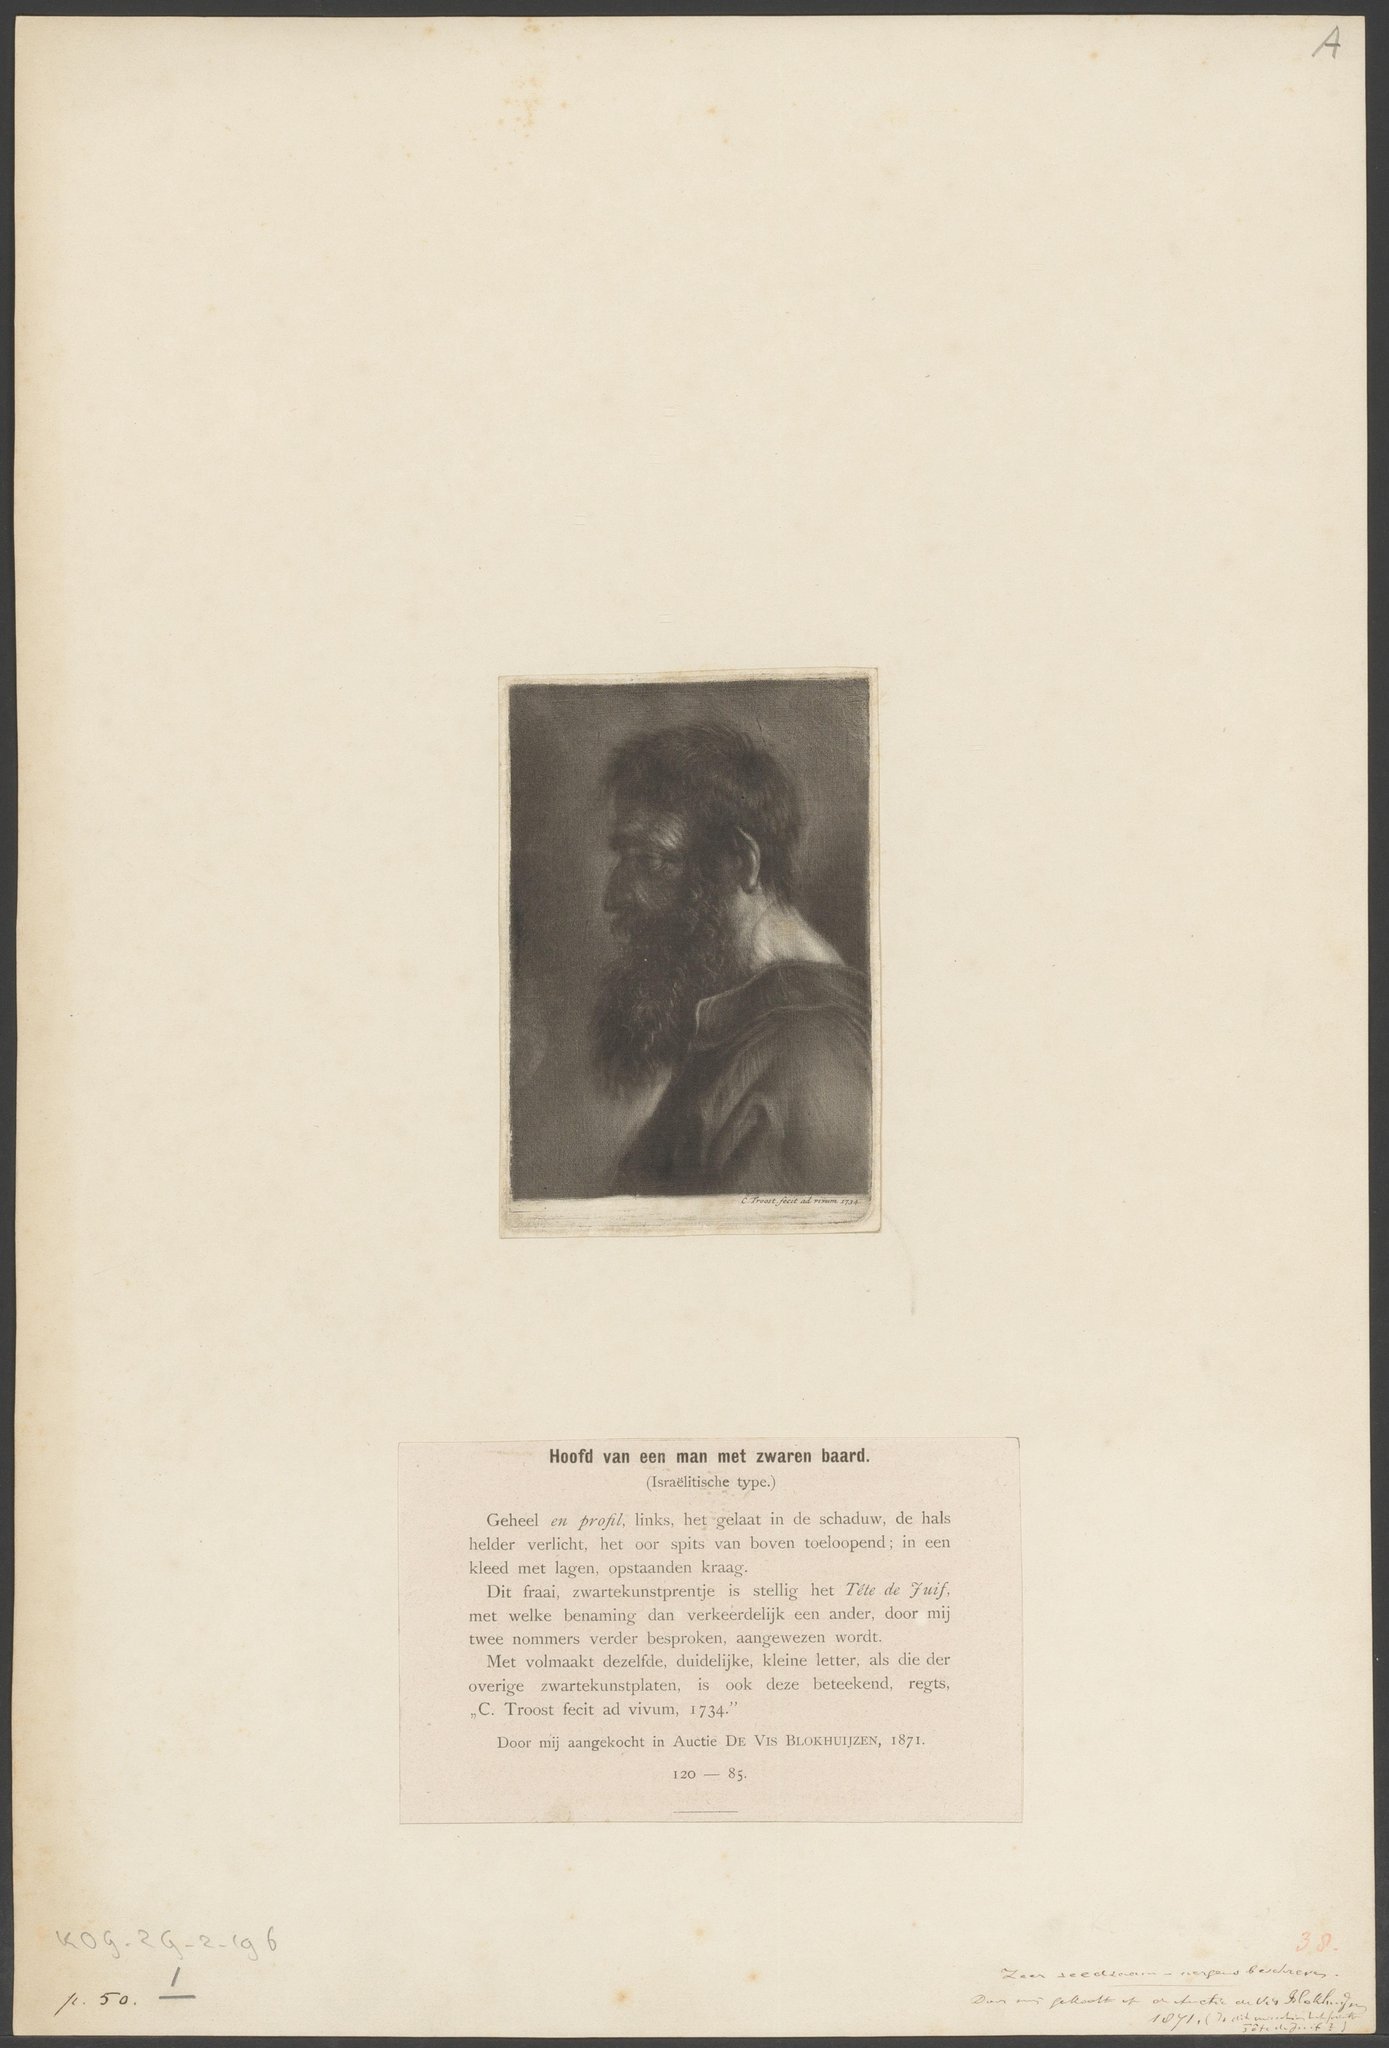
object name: print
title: Oude man met baard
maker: cornelis troost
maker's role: draughtsman, painter, print maker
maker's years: 1696-1750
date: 1734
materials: paper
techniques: mezzotint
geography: amsterdam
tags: head turned to the left, beard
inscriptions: collector's mark: Lugt 2488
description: Studie van het hoofd van een oude man met een zware baard, in profiel naar links. Ook wel eens beschreven als het hoofd van een Jood of van een 'Israëlitische type'. Op het blad onder de prent gemonteerd een uitgeknipt fragment uit het boek 'Cornelis Troost en zijn werken'.